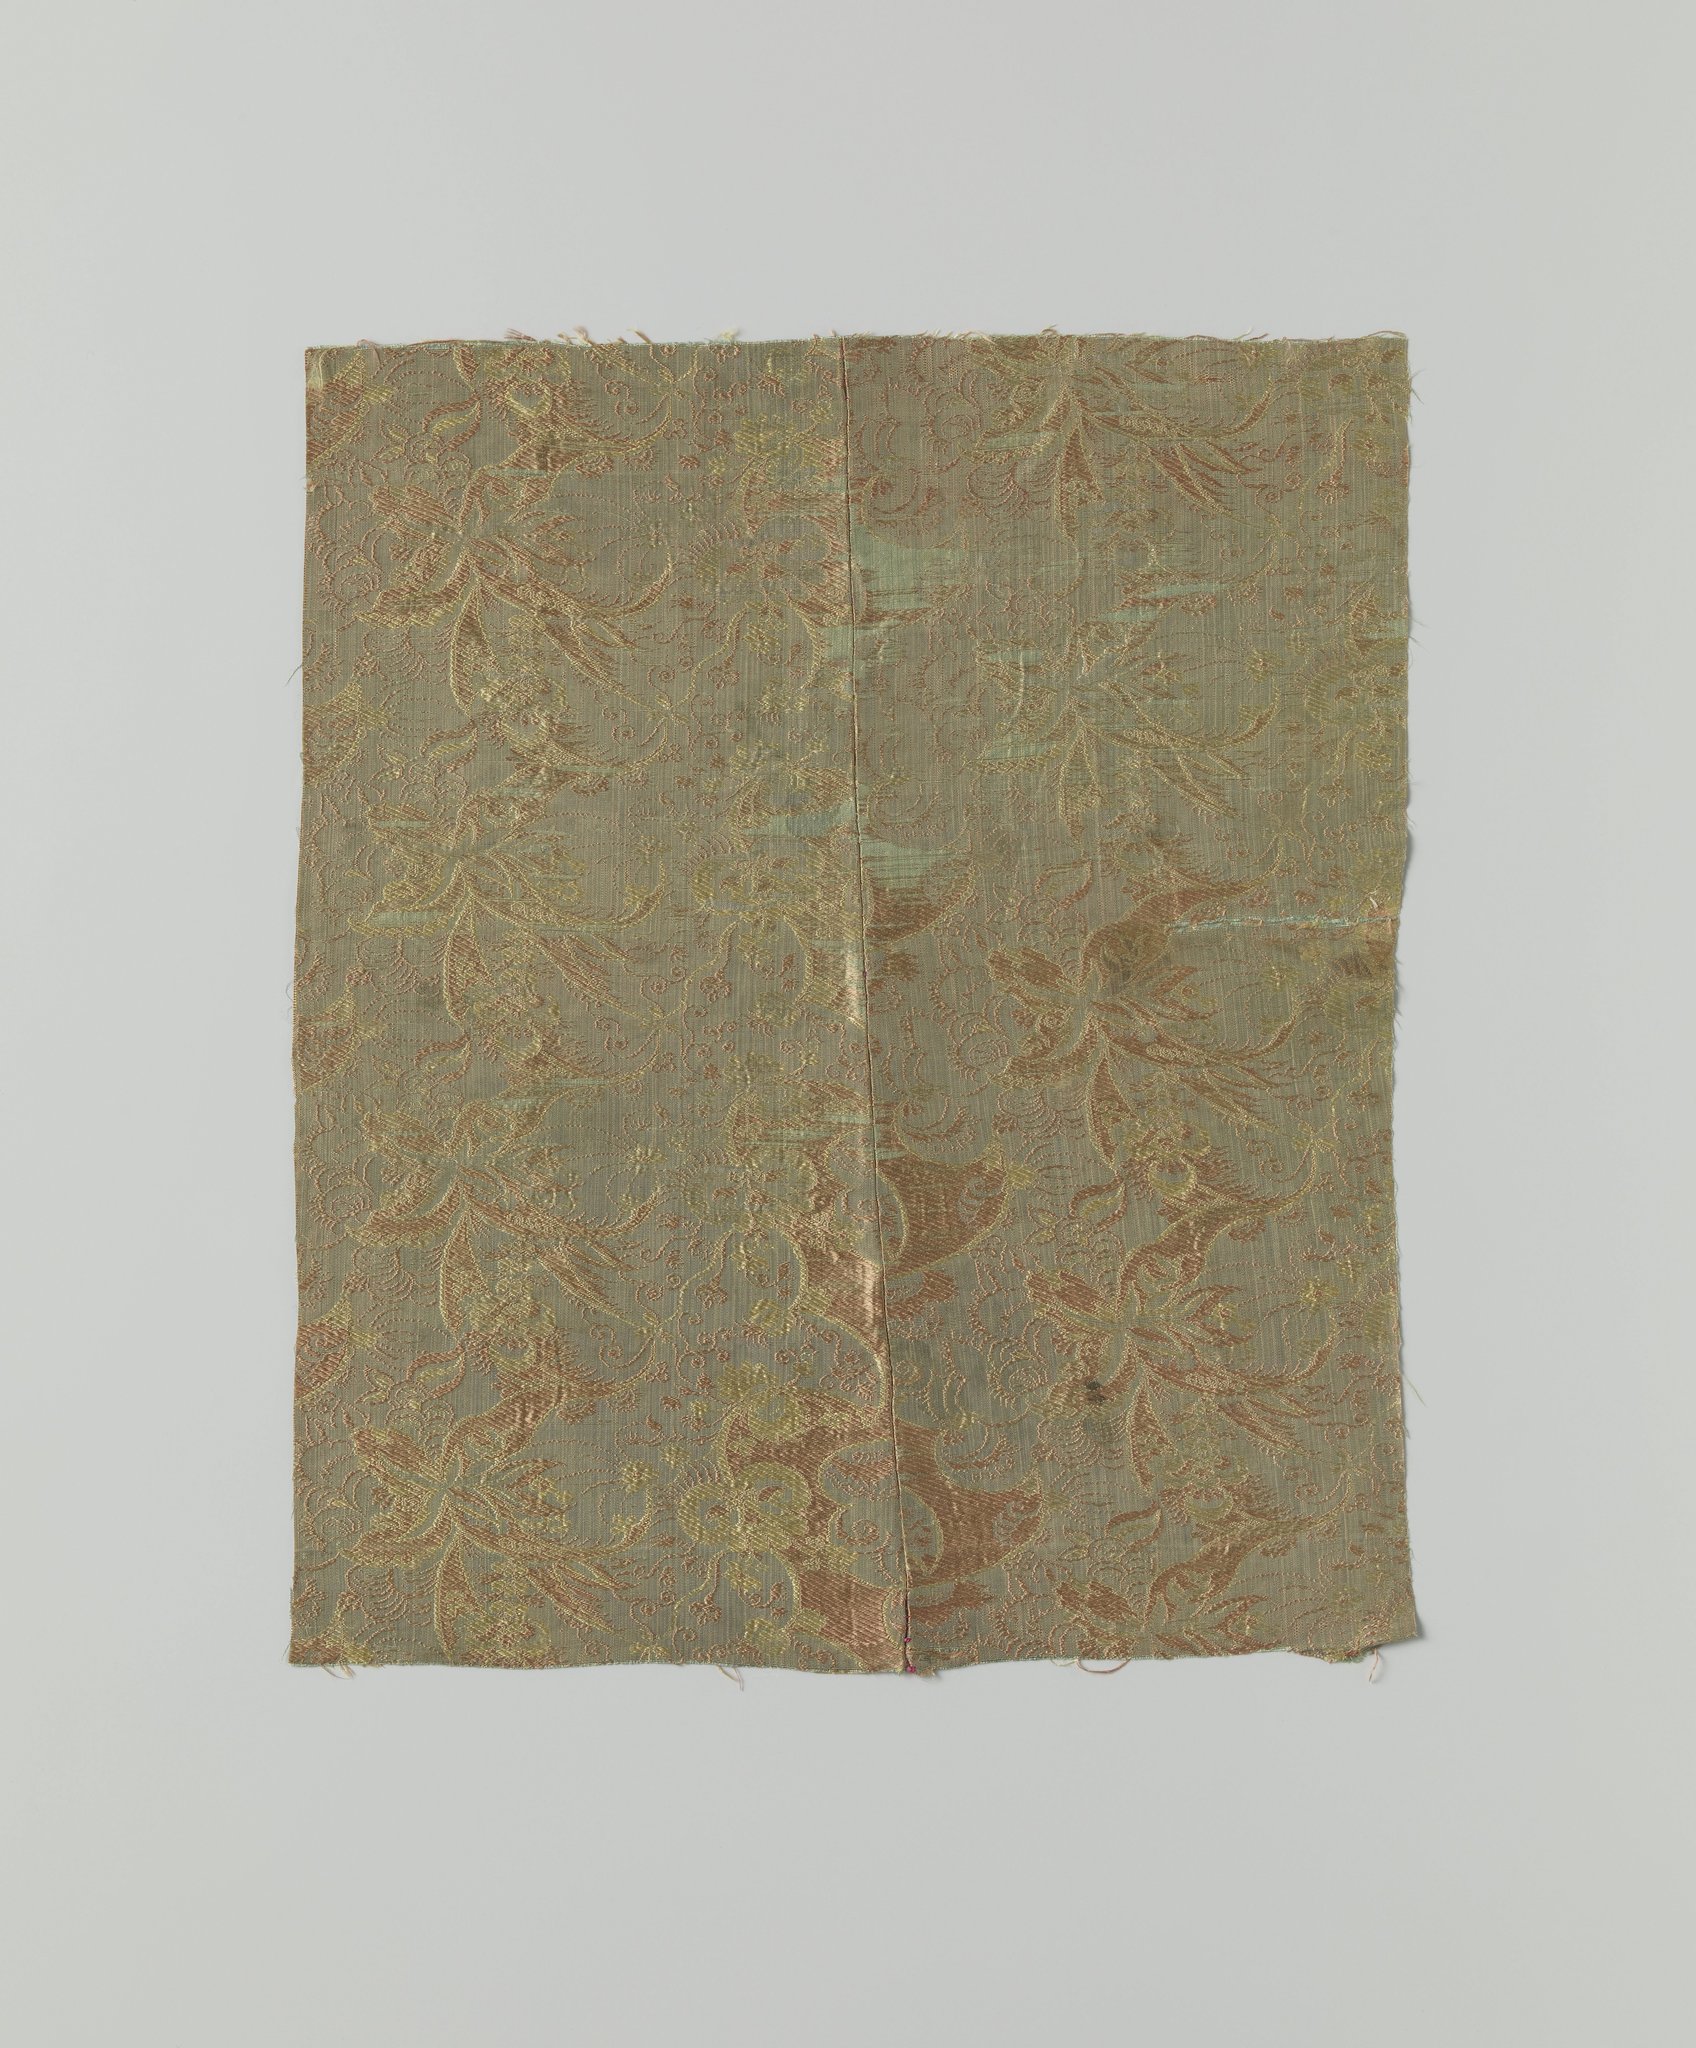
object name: fragment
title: Fragment veelkleurige gebrocheerde zijde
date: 1700-1750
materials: silk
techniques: liseré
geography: spain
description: Fragment veelkleurige zijde. Een mosgroene grond heeft een patroon van bloem- en bladvormen in rood bruin een geelgroen.